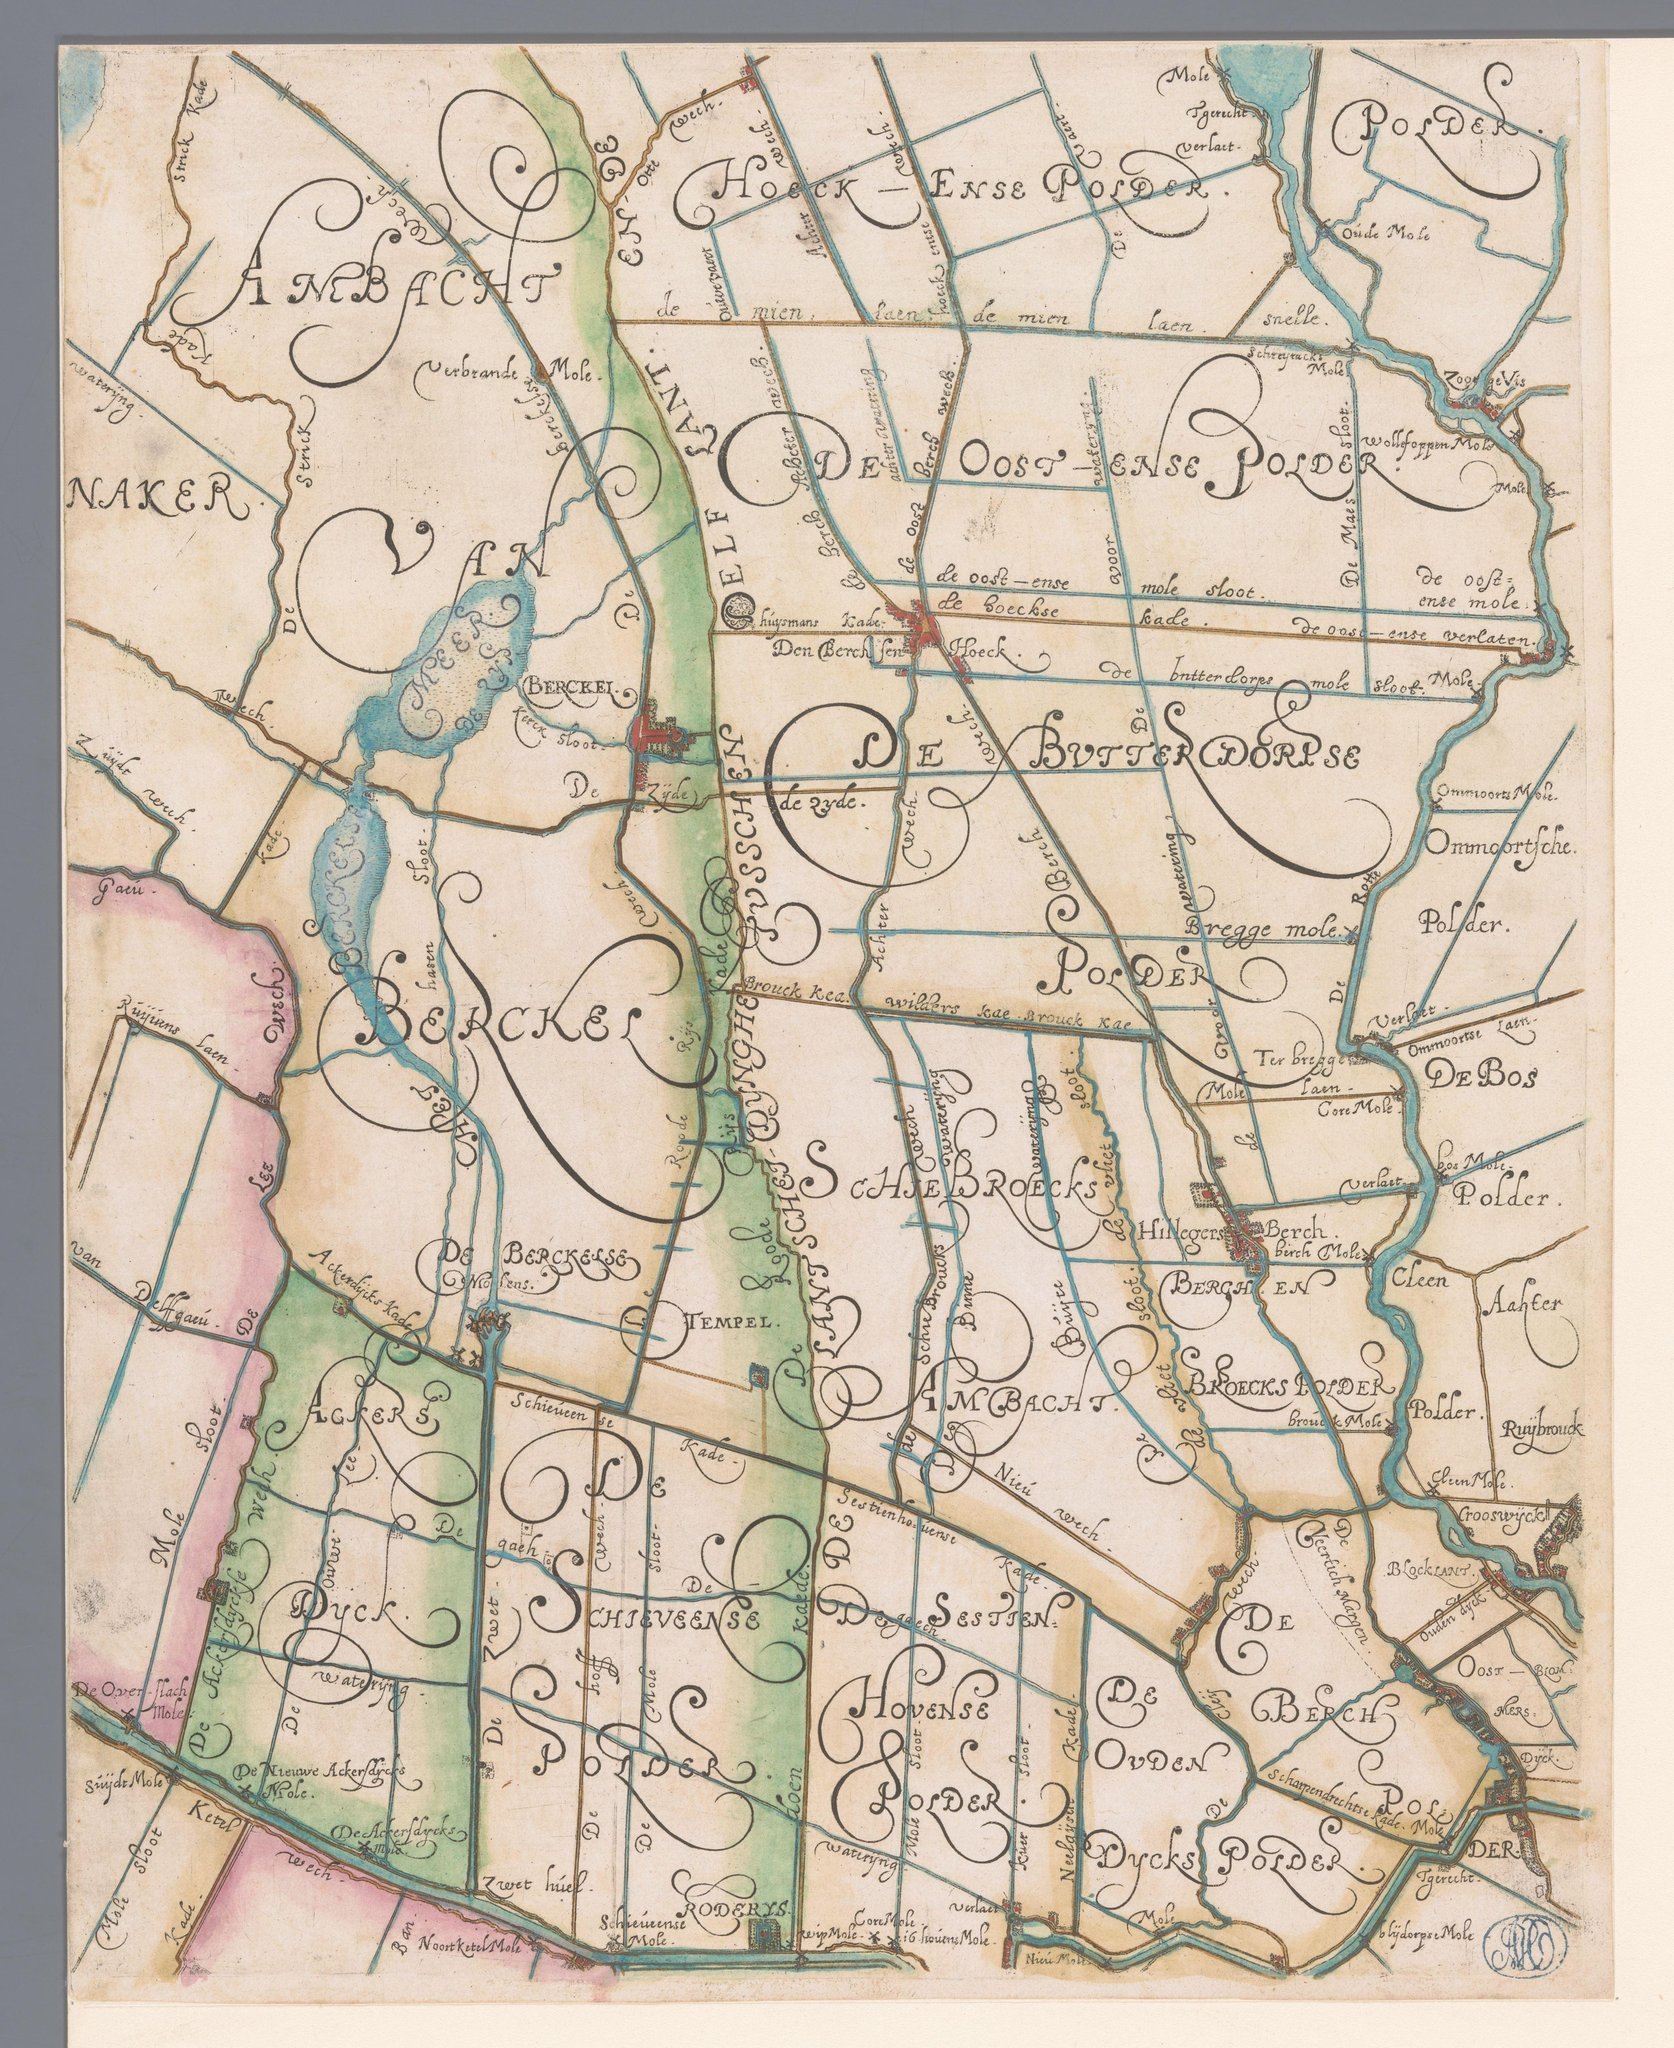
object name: print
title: Kaart van het Hoogheemraadschap van Delfland, met Berkel en Rodenrijs, deel midden rechts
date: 1611-1692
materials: paper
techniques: engraving, etching, hand coloring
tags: maps of separate countries or regions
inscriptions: collector's mark: Lugt 195